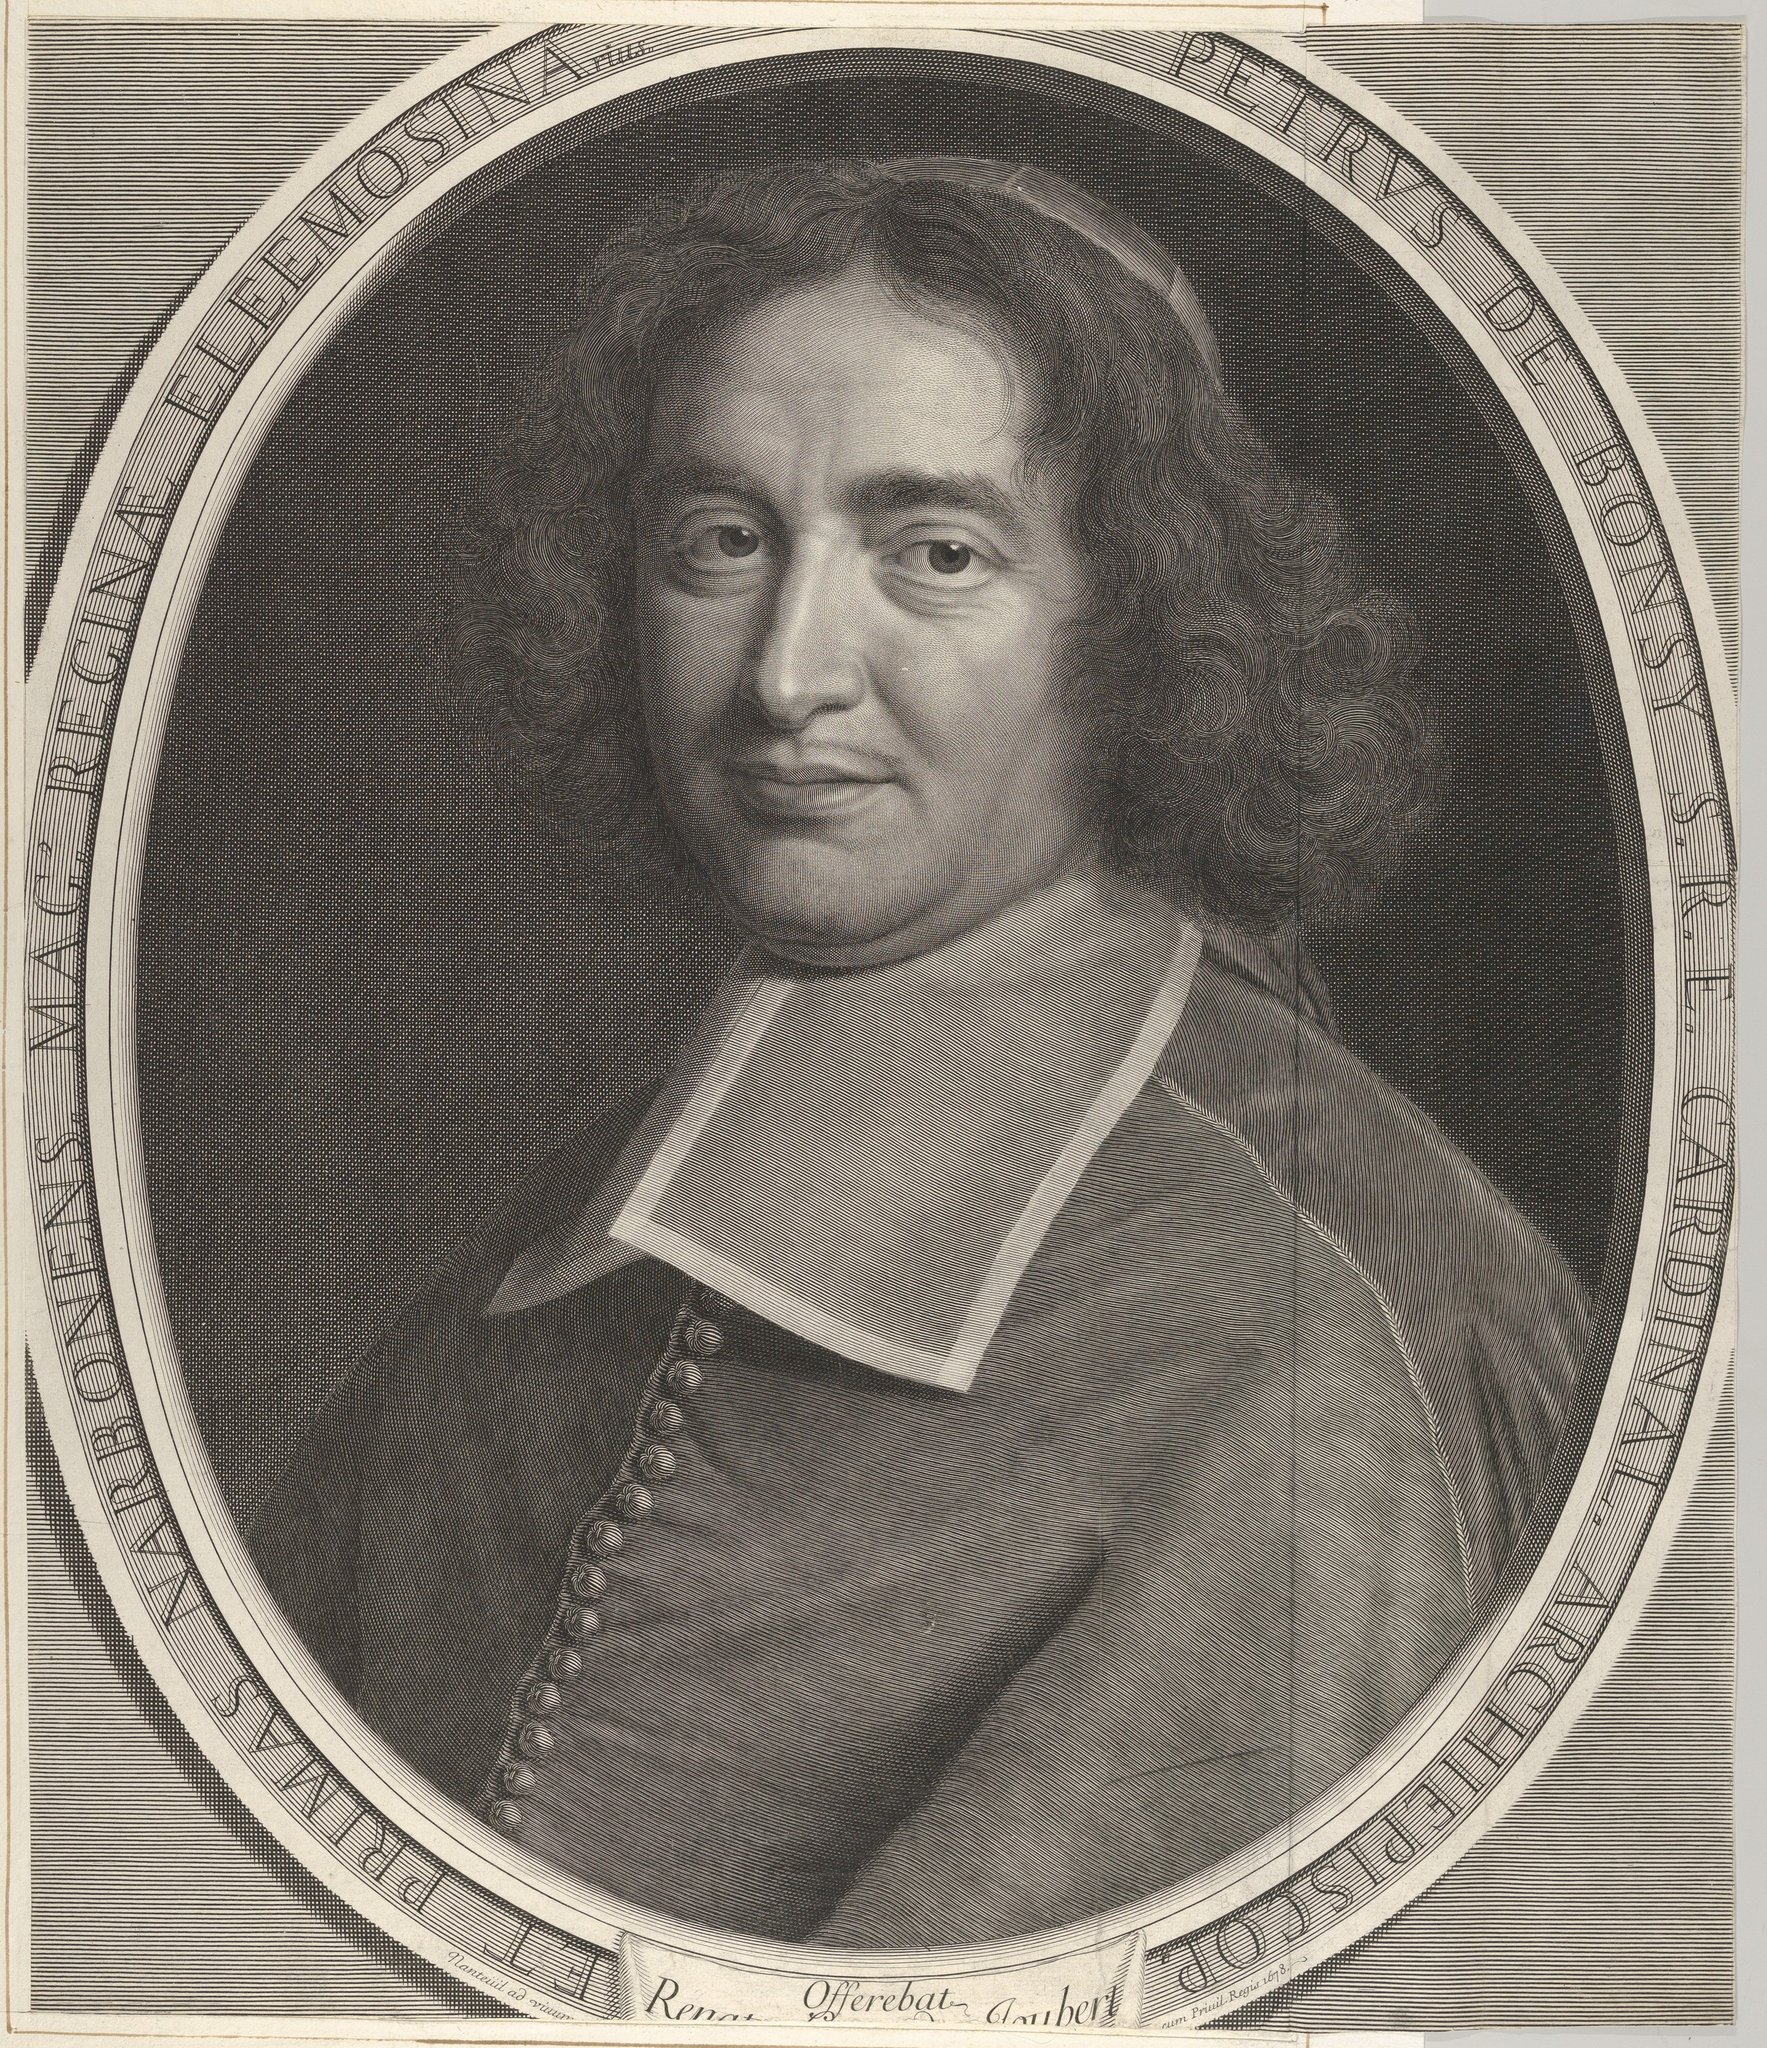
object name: print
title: Le cardinal Pierre de Bonzi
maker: robert nanteuil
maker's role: artist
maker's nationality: french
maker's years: 1623-1678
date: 1678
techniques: engraving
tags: men,portraits